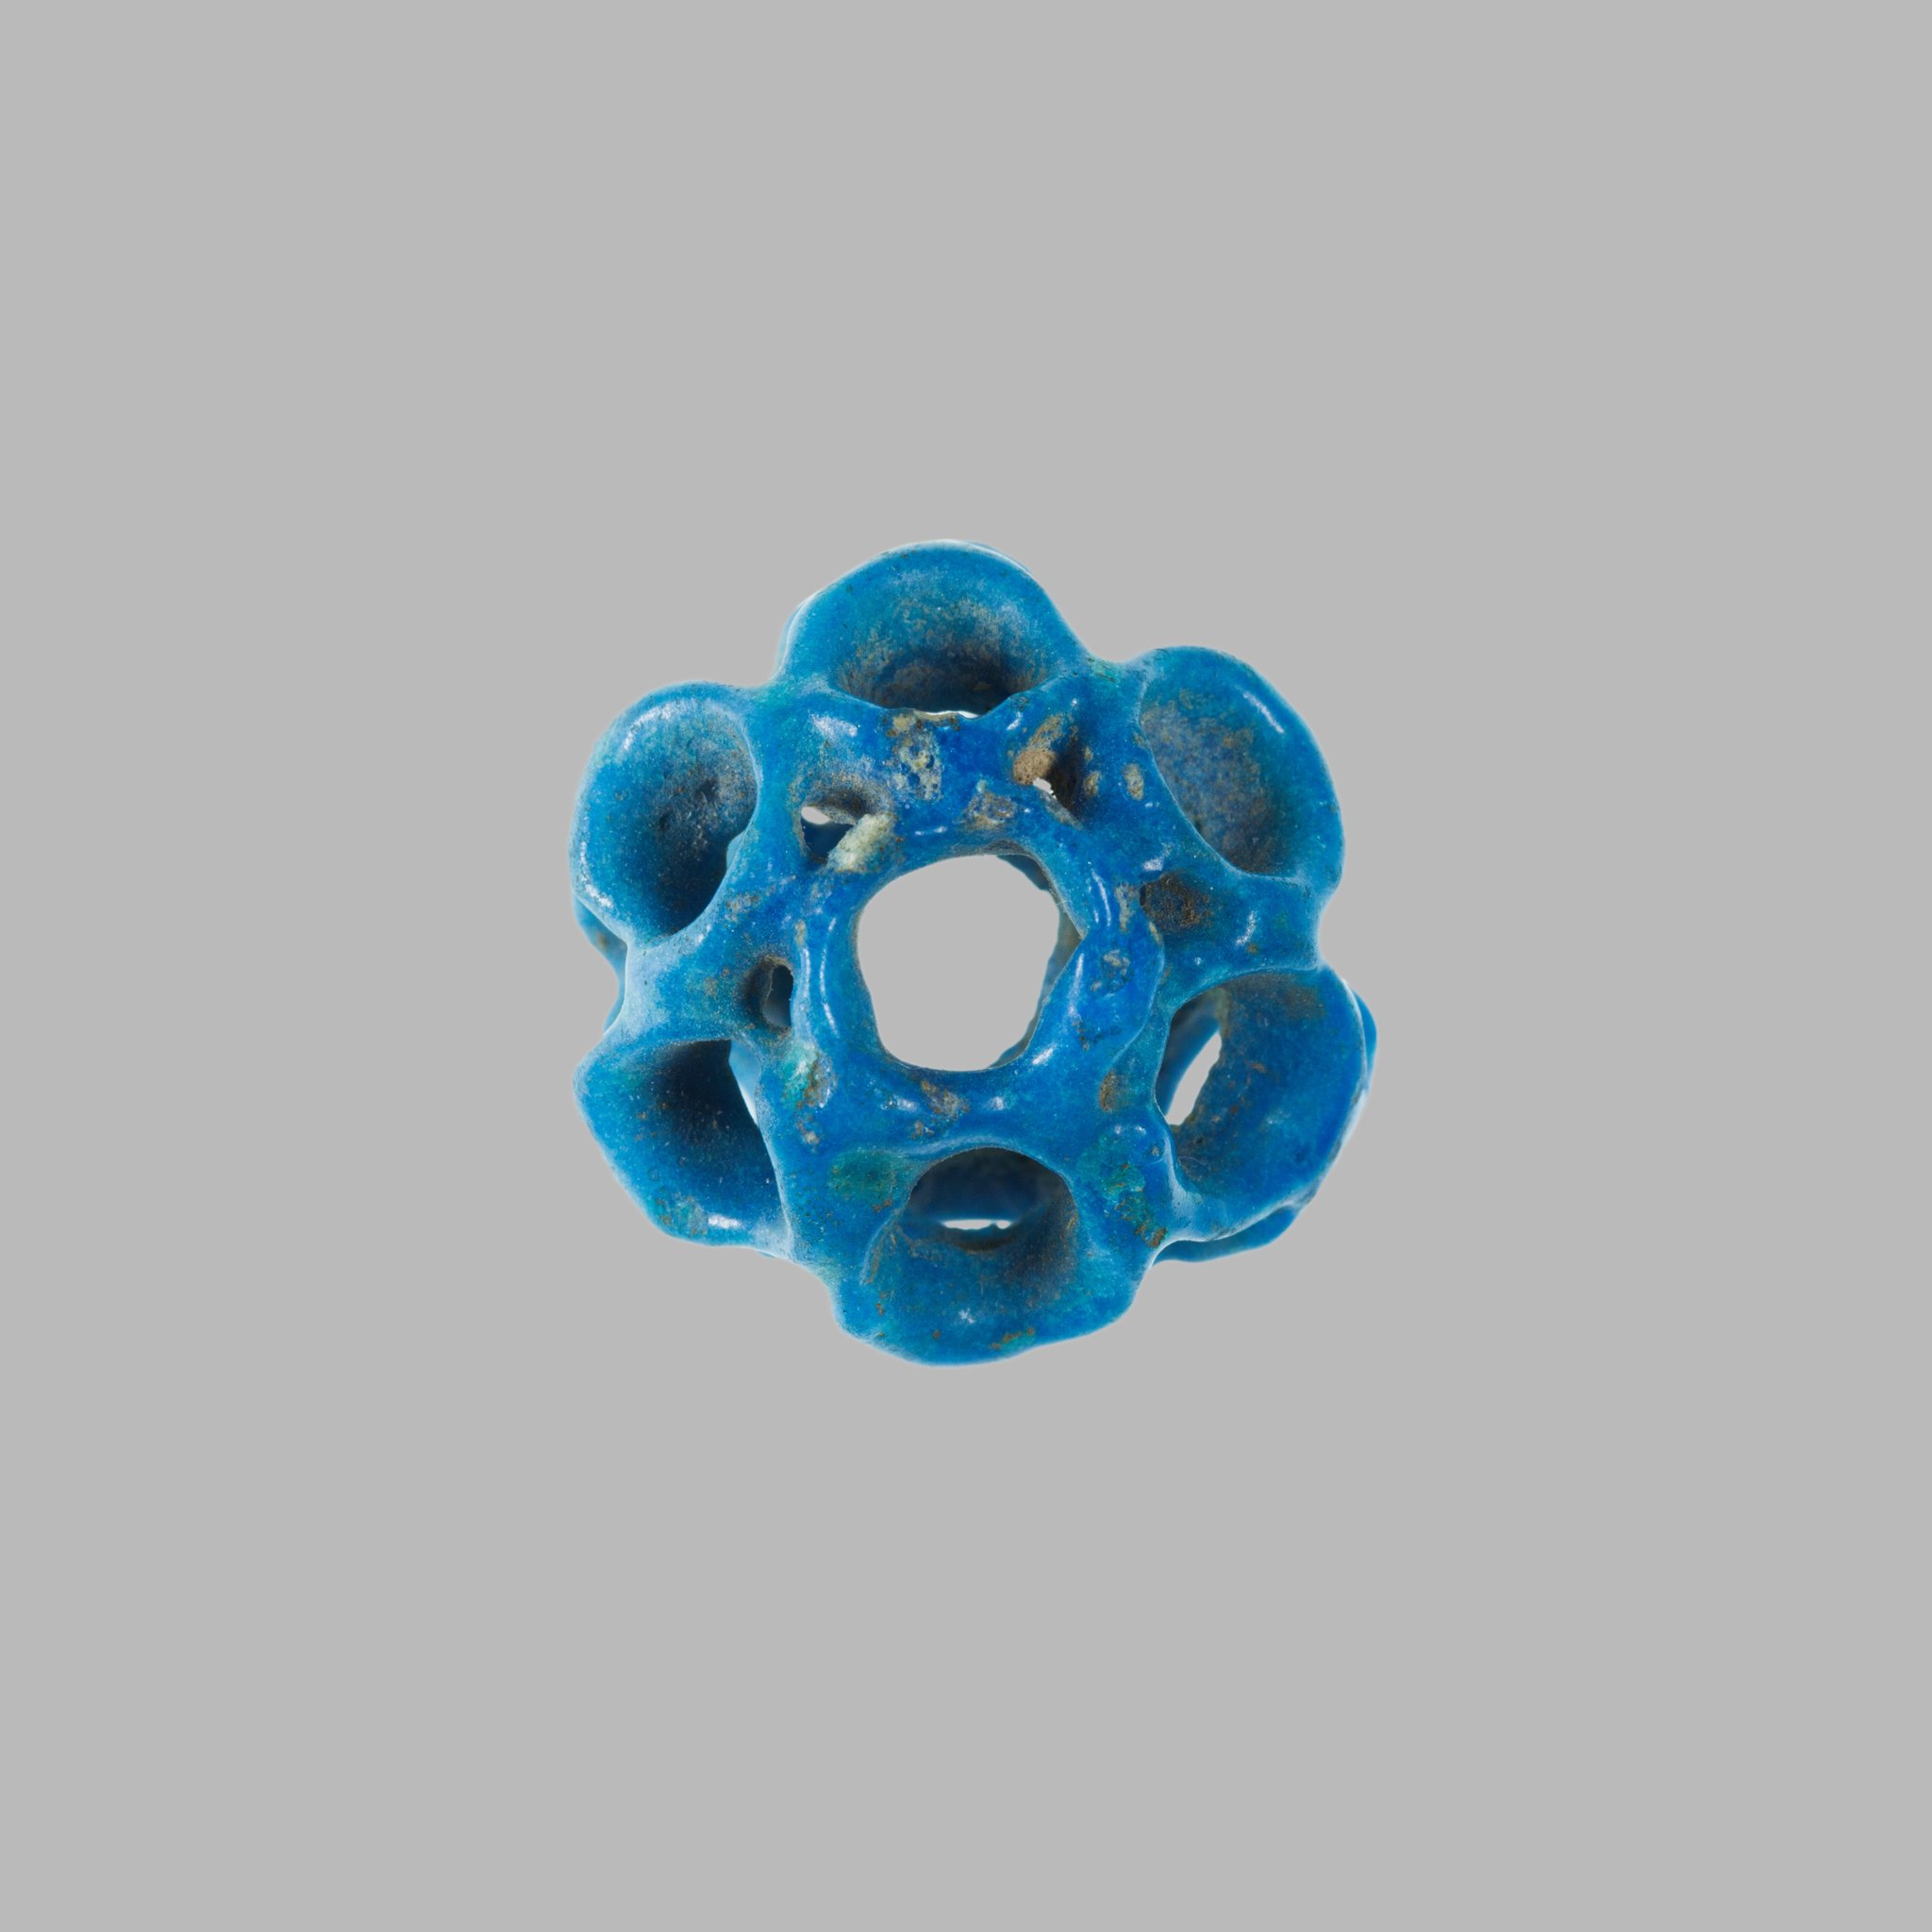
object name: bead, openwork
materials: faience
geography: egypt